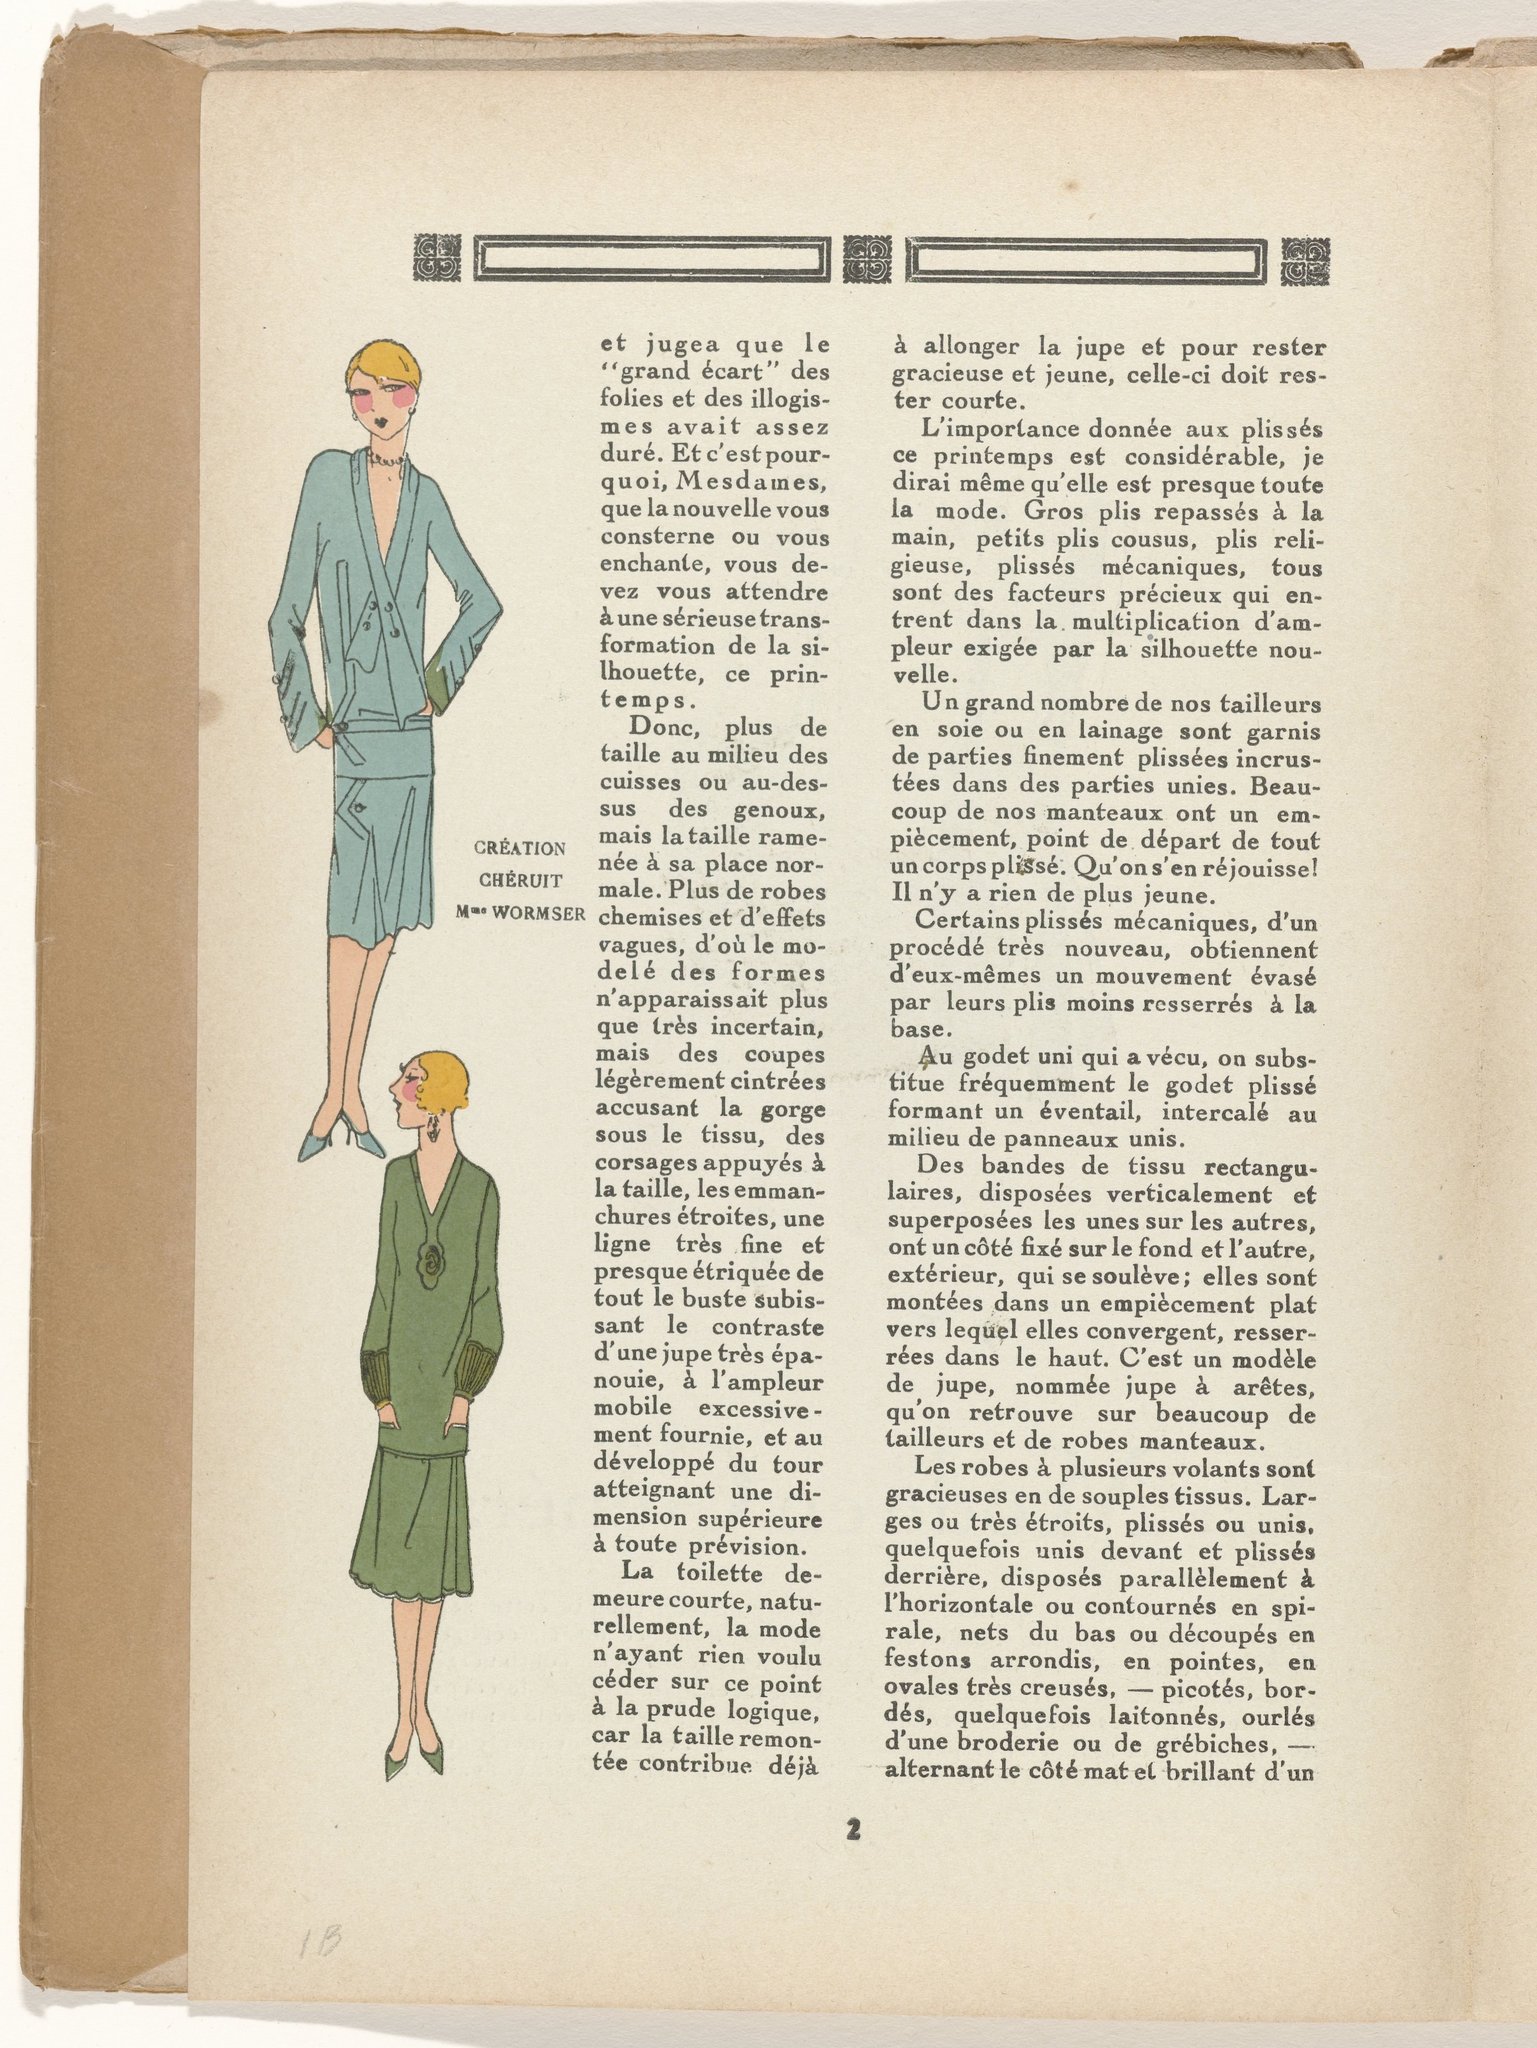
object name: fashion print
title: Très Parisien, 1926, No. 2, pag. 2: La Mode en Général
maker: g-p. joumard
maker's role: publisher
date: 1926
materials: paper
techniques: hand coloring, letterpress printing, lithography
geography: paris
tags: dress, gown: day dress (+ women's clothes), fashion plates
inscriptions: date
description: Pagina 2 uit Très Parisien, No. 2, 1926: tekst van 'Solange', met illustratie van een creatie van Chéruit, Mme Wormser.